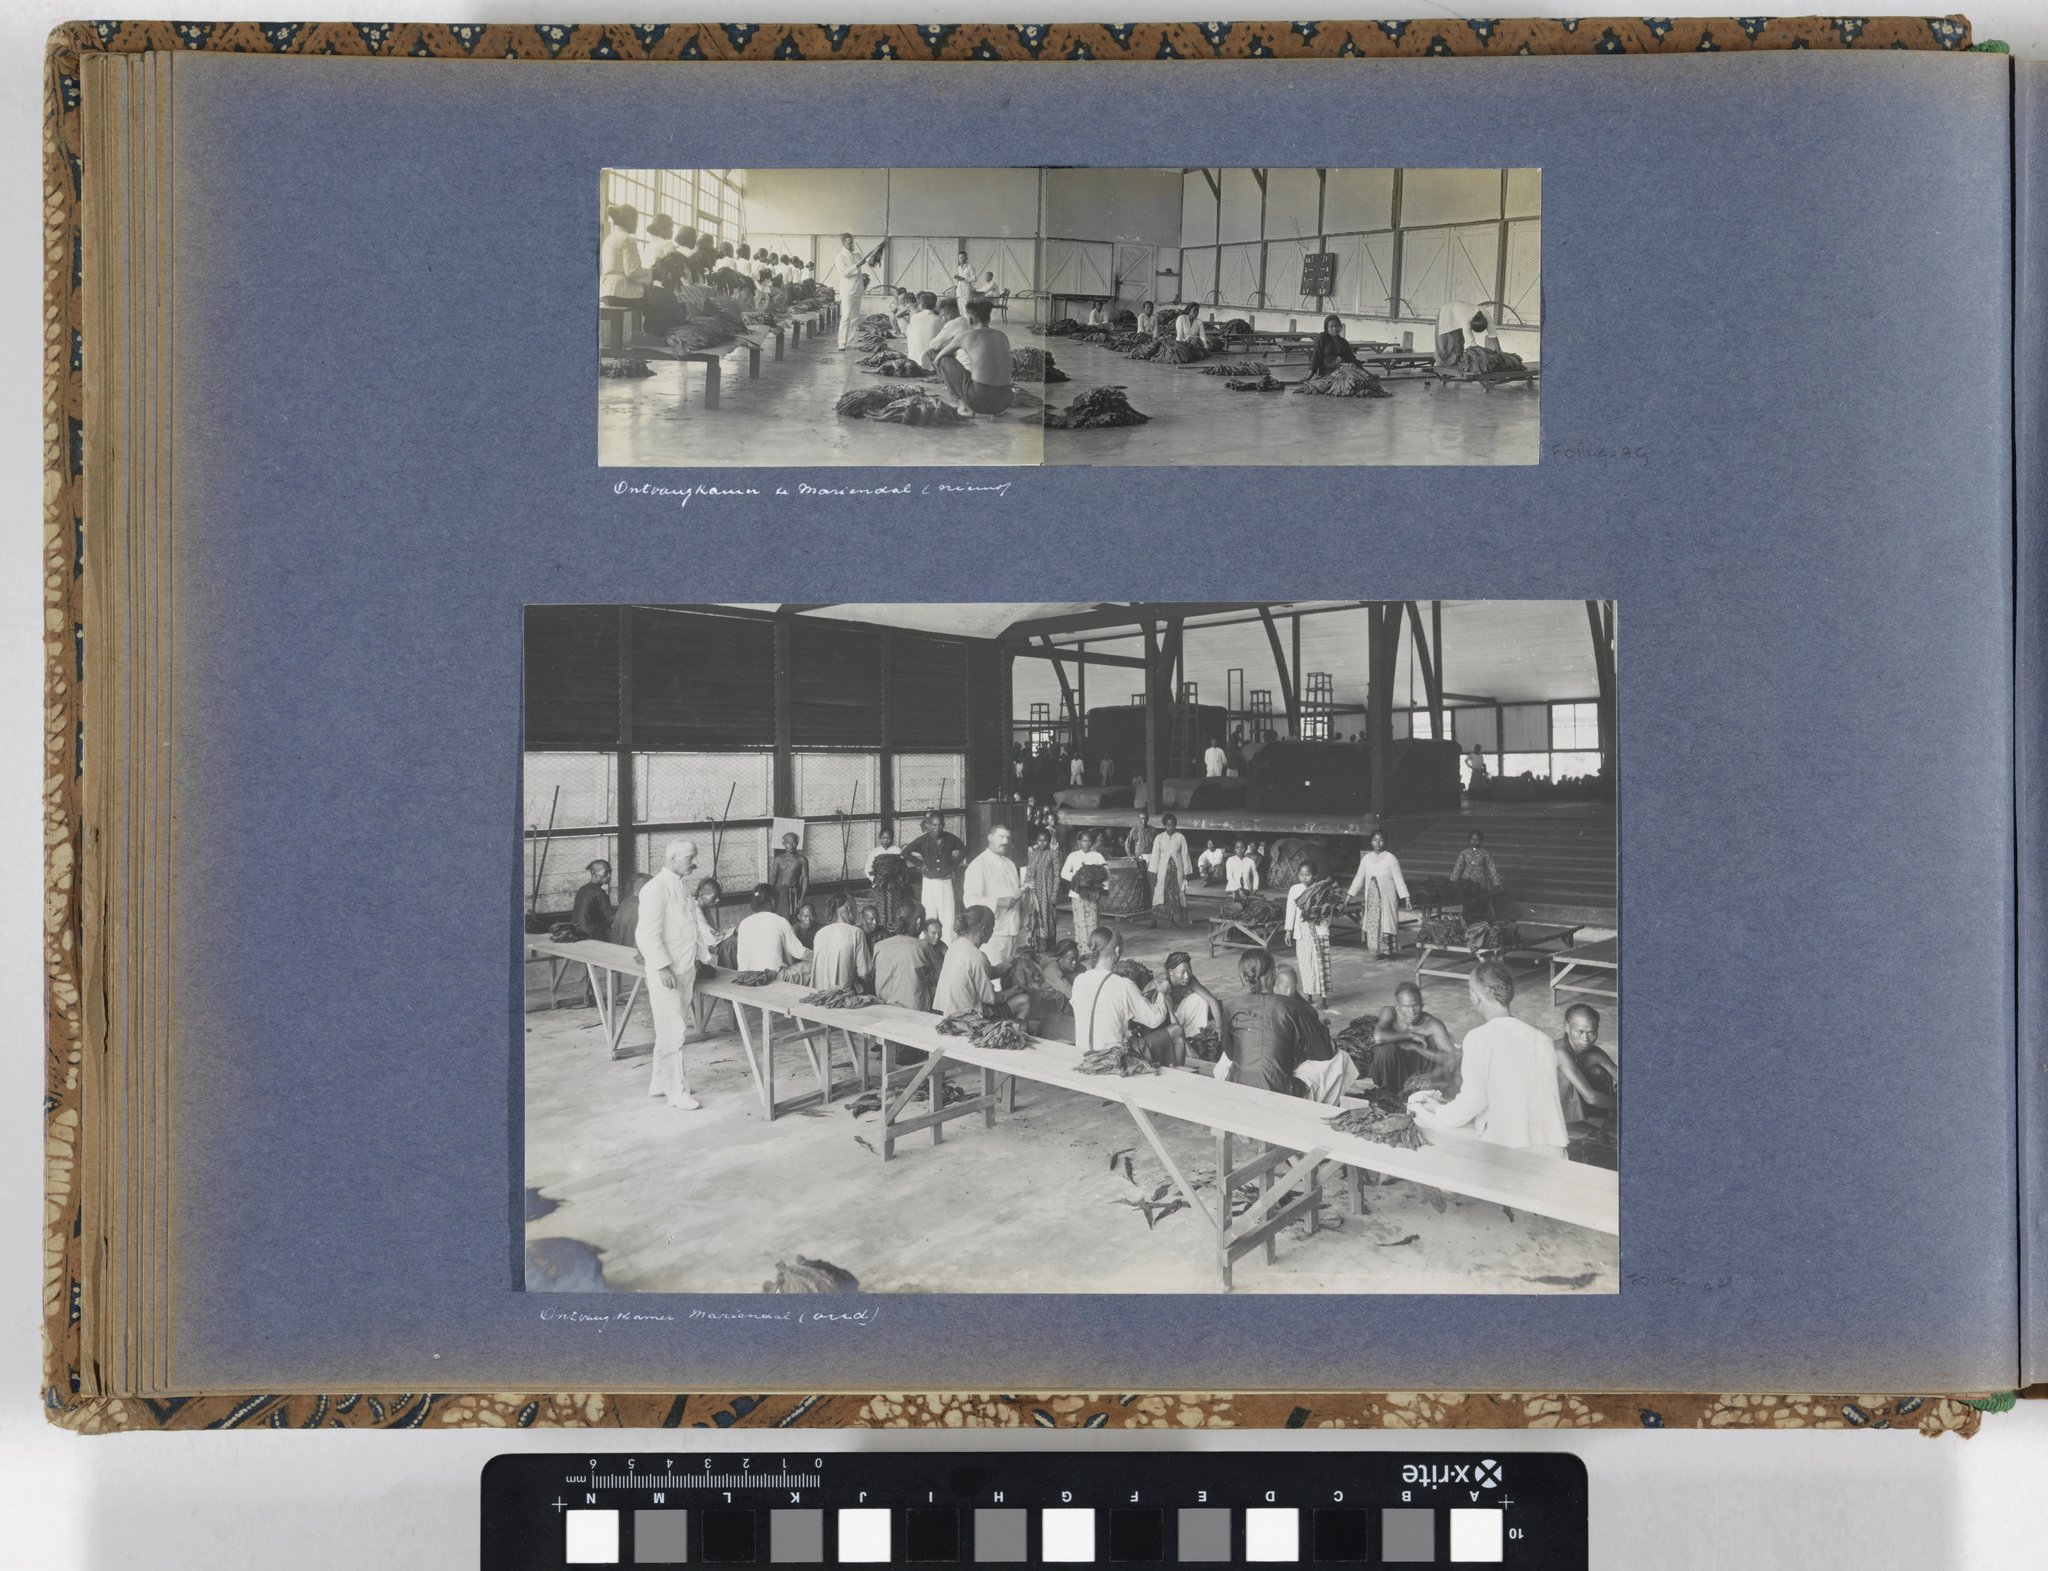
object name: album leaf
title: Indische en Europese werknemers in de oude ontvangkamer van tabaksplantage Mariendal op Sumatra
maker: carl j. kleingrothe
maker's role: fotograaf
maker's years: 1864-1925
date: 1900-1915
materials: paper, photographic support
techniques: gelatin silver print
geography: sumatra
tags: plantation, working class, labourers, tobacco, sumatra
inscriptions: name: ‘Kleingrothe O.K.v.Sumatra’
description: De mannen met tabaksbladeren vooraan zijn Chinese contractarbeiders. Onderdeel van reisalbum met foto's van bedrijvigheid en bezienswaardigheden op Sumatra en Java en van de reis naar en van Nederlands-Indië.